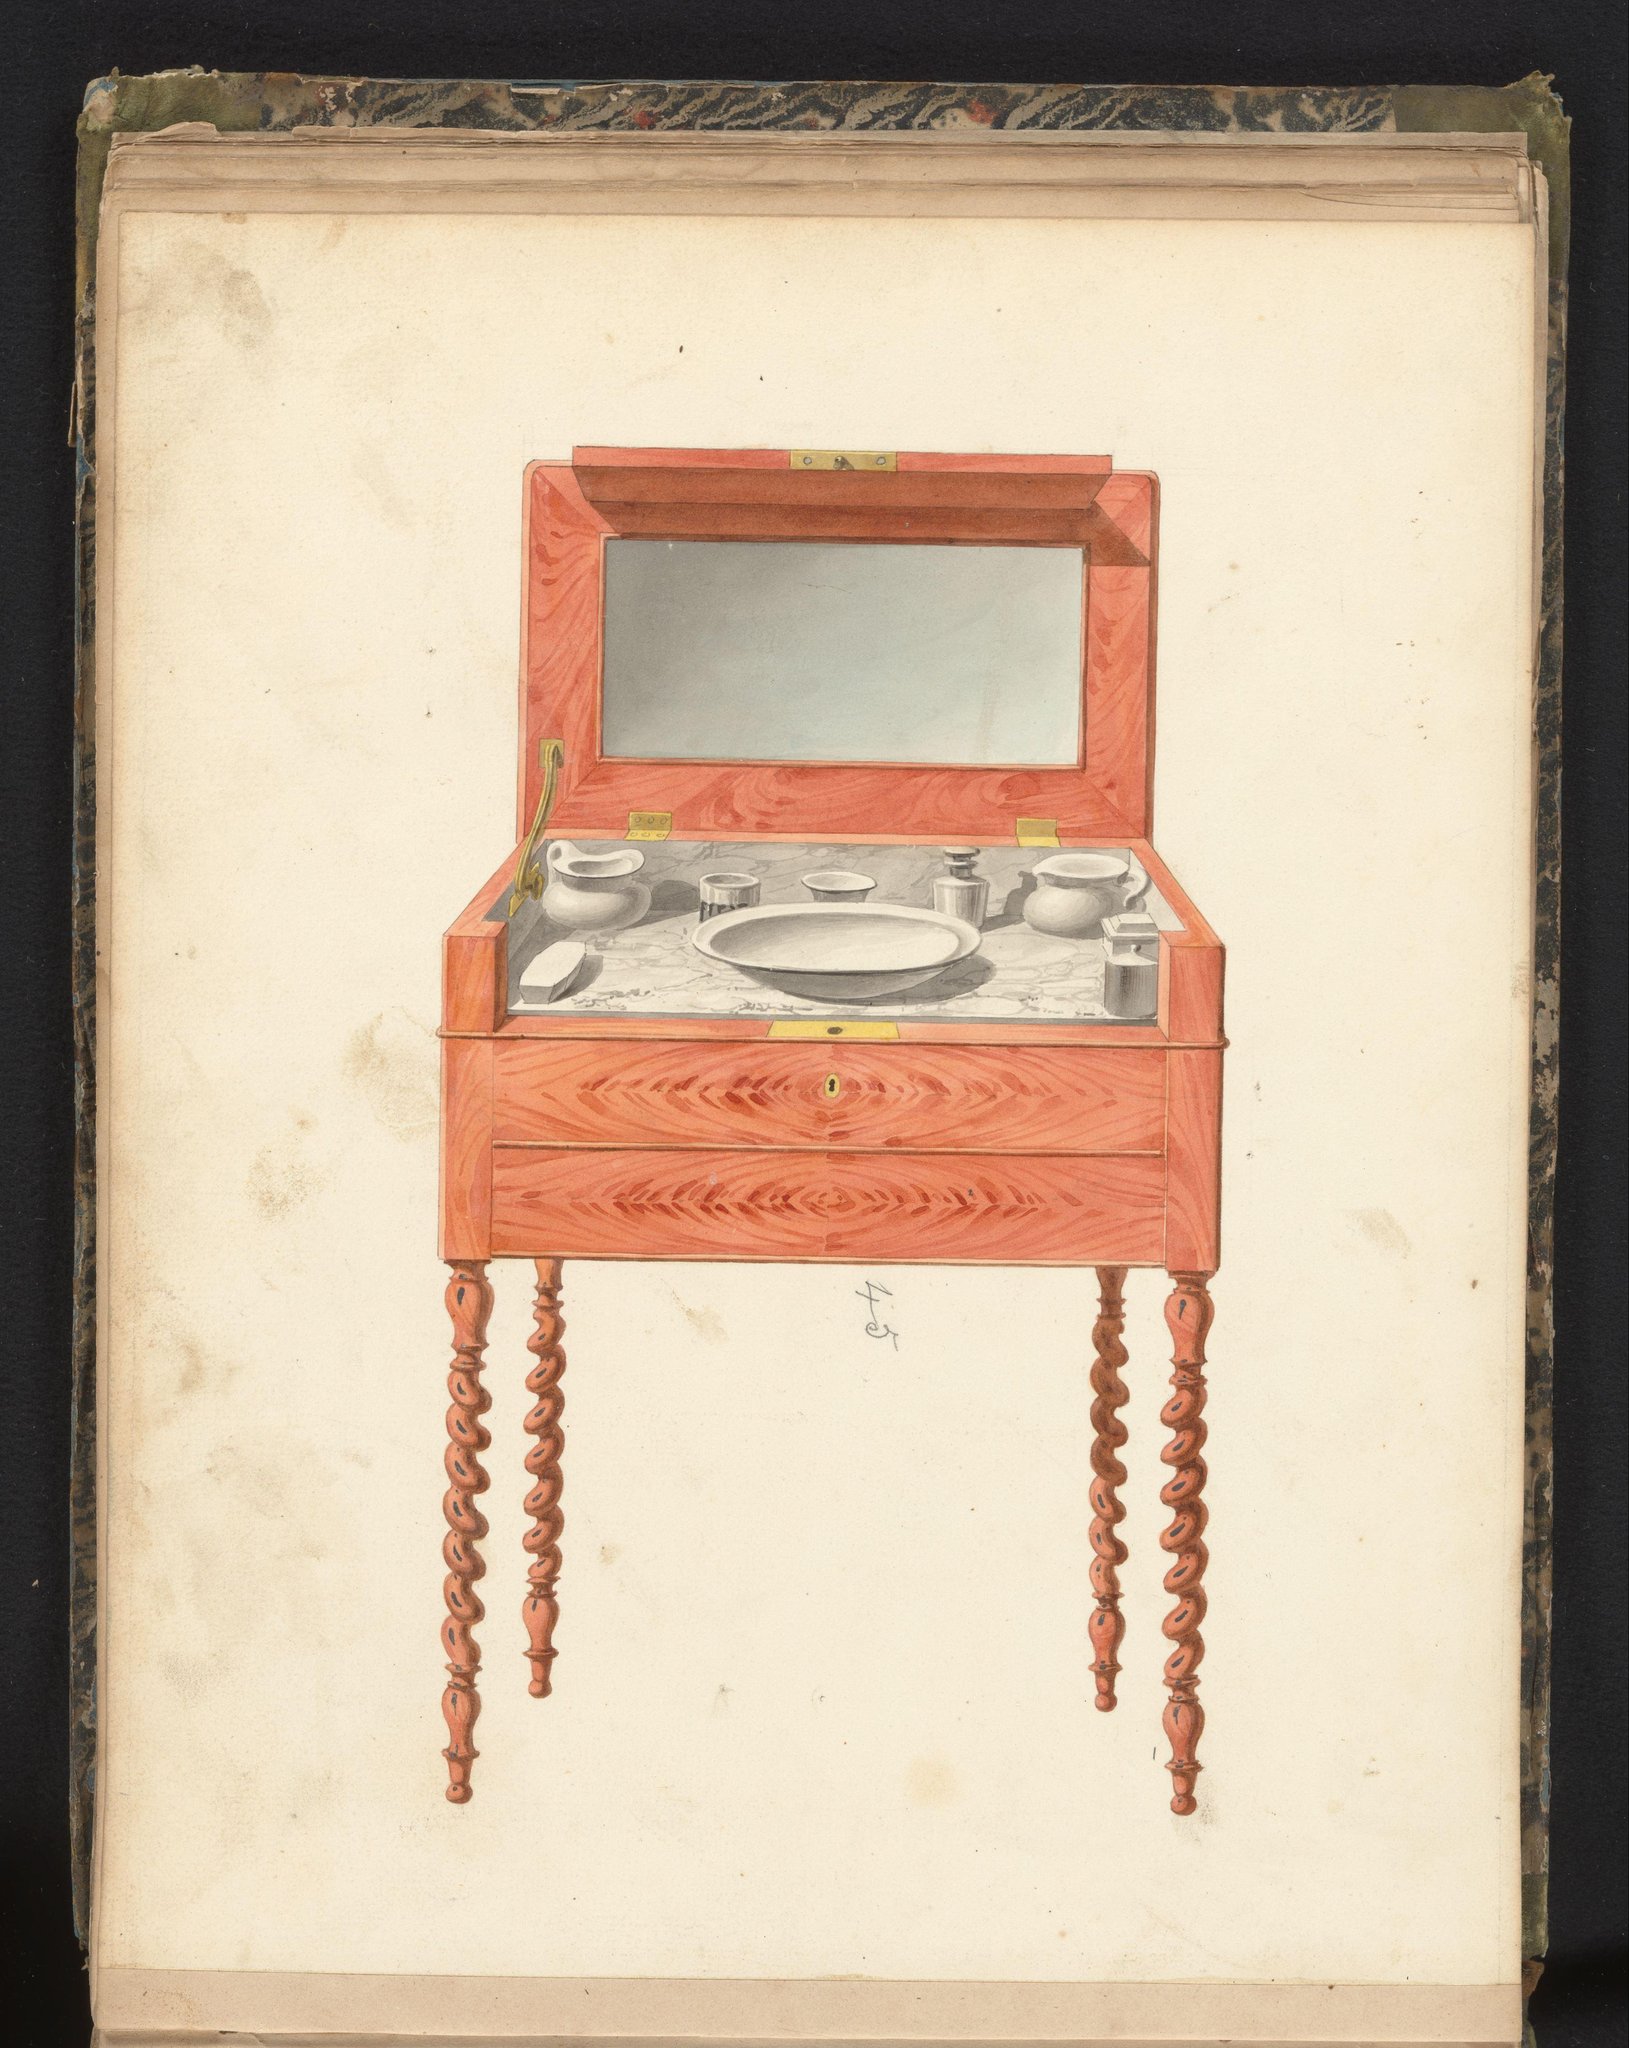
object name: album leaf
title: Ontwerp voor een toilettafel voor mannen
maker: Anonymous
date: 1825-1839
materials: ink, paper, pencil, watercolor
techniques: brush, pen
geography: paris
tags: mirror, jug and basin; wash-basin, furniture for special use (+ wood and other phytogenic material), table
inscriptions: inscription: ‘45 Toilette d’homme a couvercle pies torse gre (gu?) 9 piece 30 aux gre & retour marbre ‘’…’’ */ pies 2*/* s/ serrure ni rebour, marbre’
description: Ontwerp voor een toilettafel voor mannen op geslingerde poten, met deksel. Aan de binnenkant een marmeren blad en ingebouwde spiegel. Als een commode weergegeven. Met slot. Het blad op de achterzijde genummerd: 9, het tegenoverliggende blad met informatie over de afgebeelde meubelen genummerd: 9 bis. Onderdeel van een album met 80 bladen met tekeningen en een prent van gefineerde en gelakte meubelen, alsmede zitmeubelen.